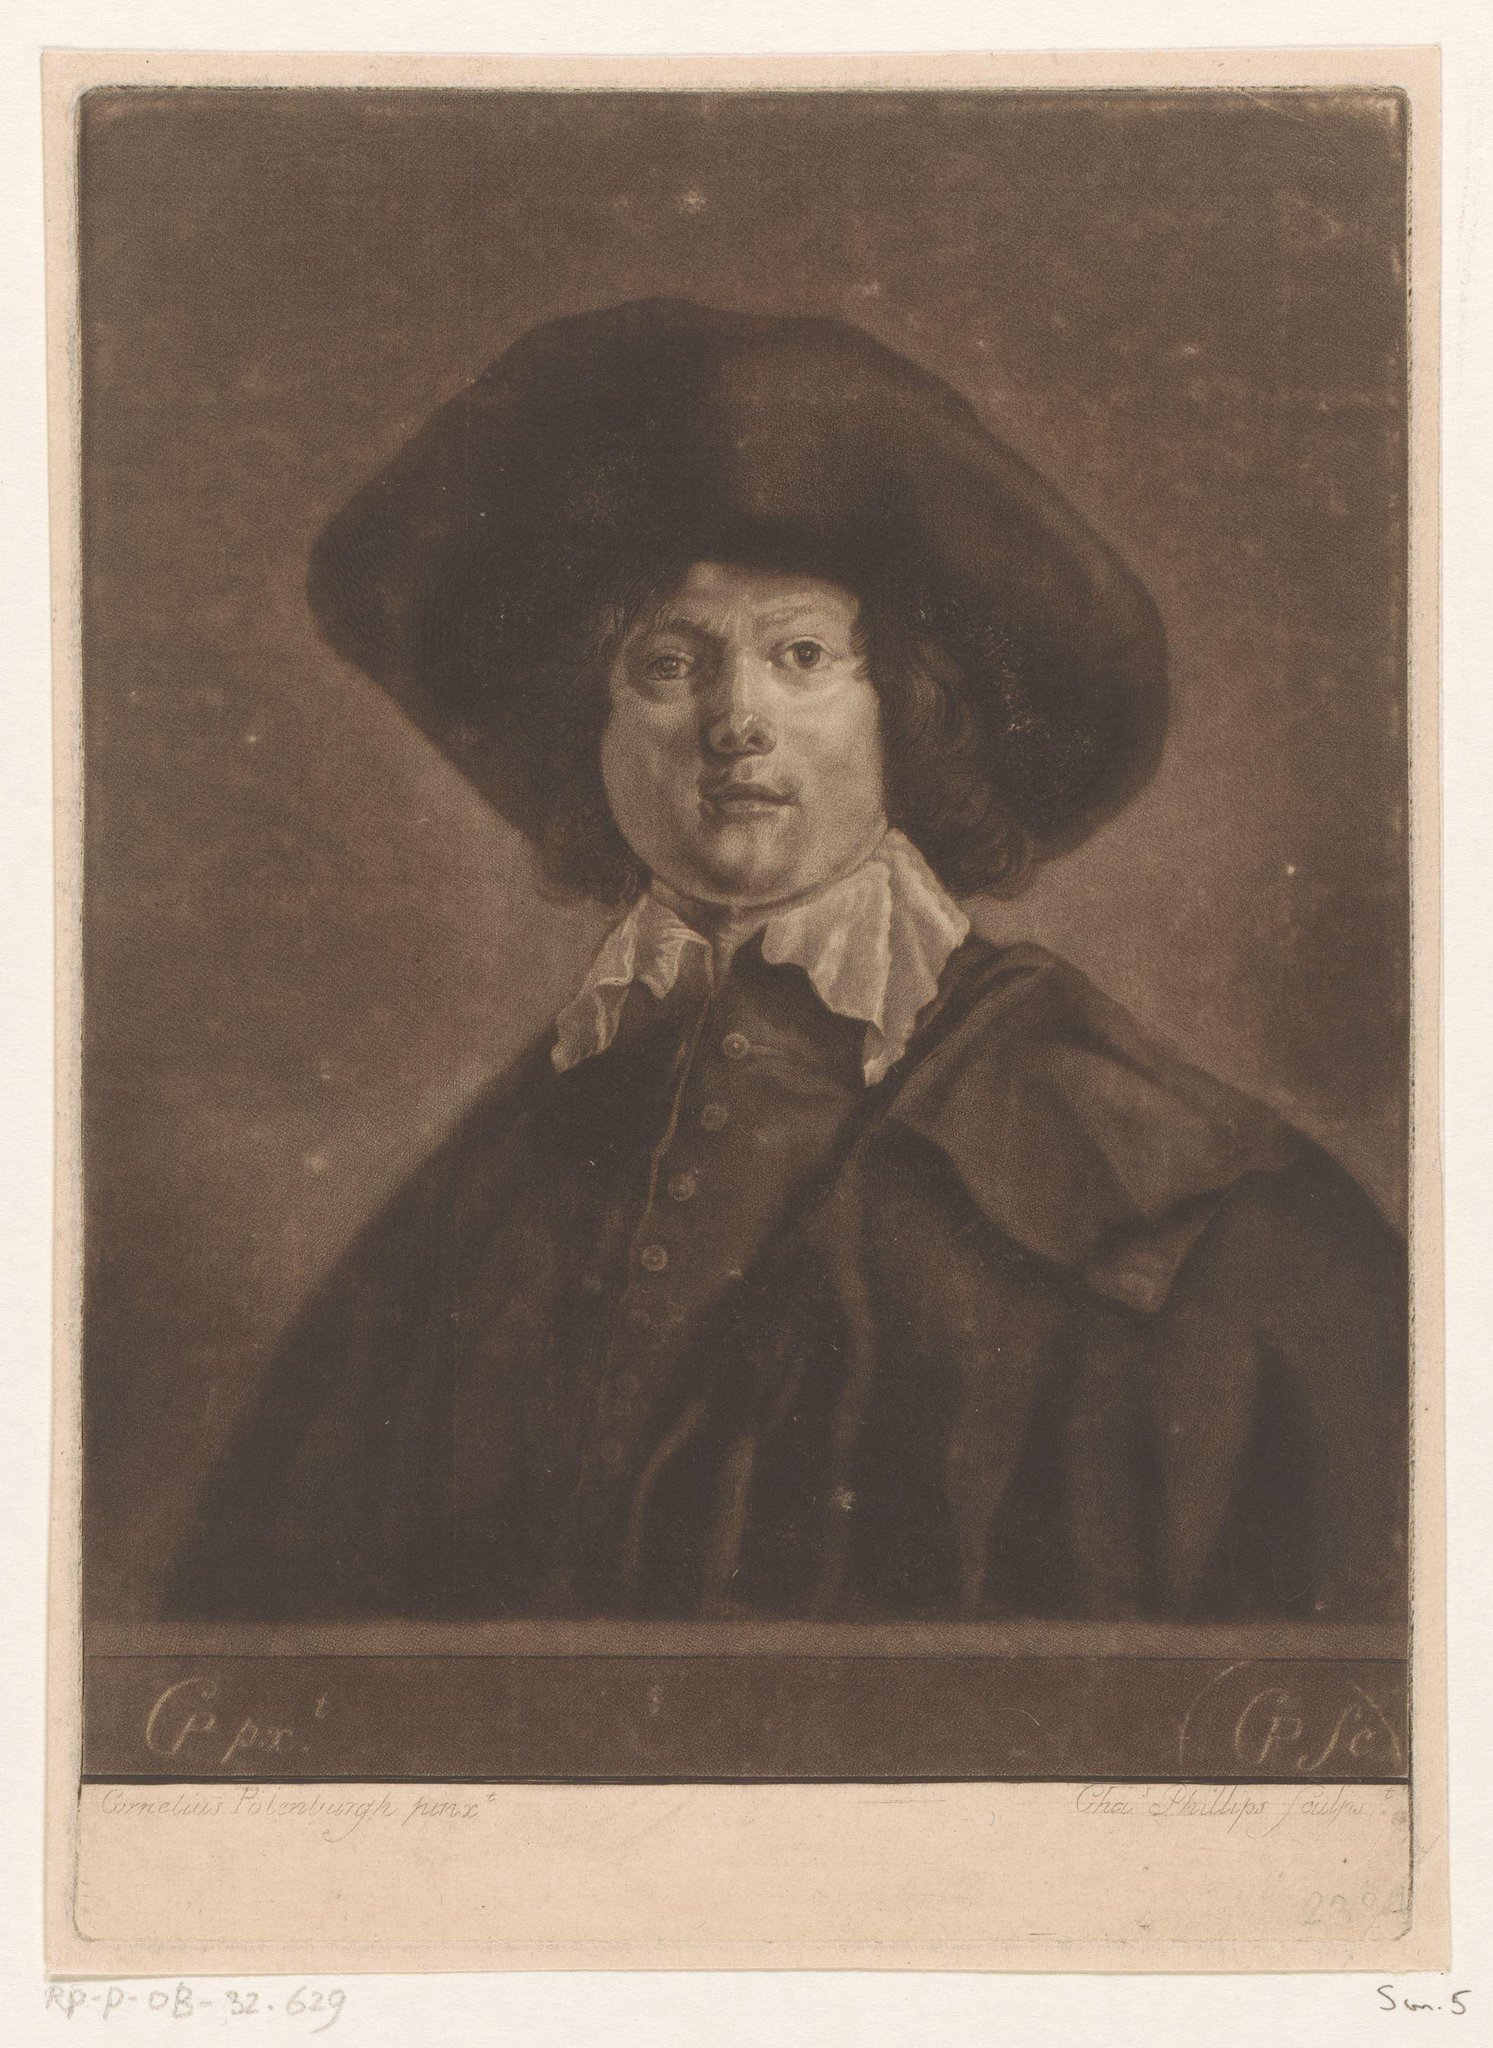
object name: print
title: Portret van een onbekende man met een hoed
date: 1747-1773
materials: paper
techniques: mezzotint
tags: historical persons, head-gear: hat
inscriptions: collector's mark: Lugt 240